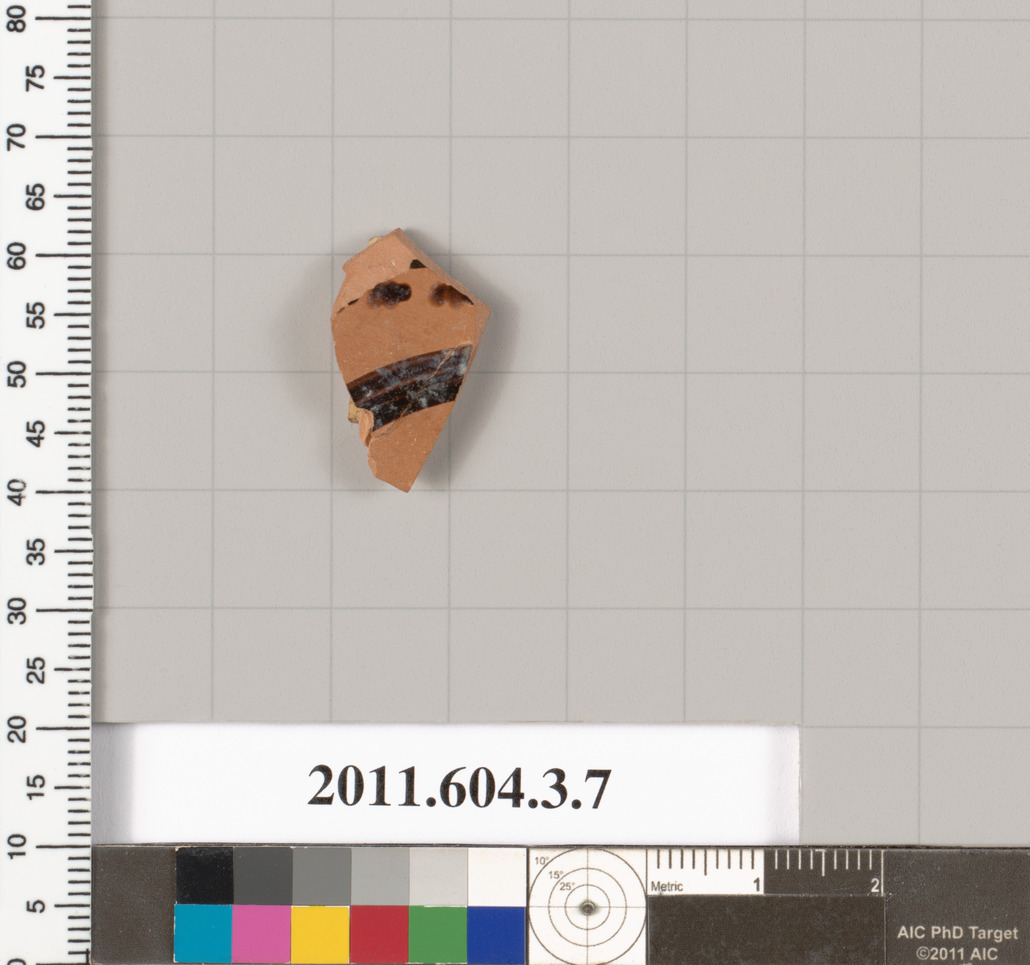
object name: undetermined shape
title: Terracotta fragment of an undetermined shape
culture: greek, attic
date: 534-468 BCE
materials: terracotta